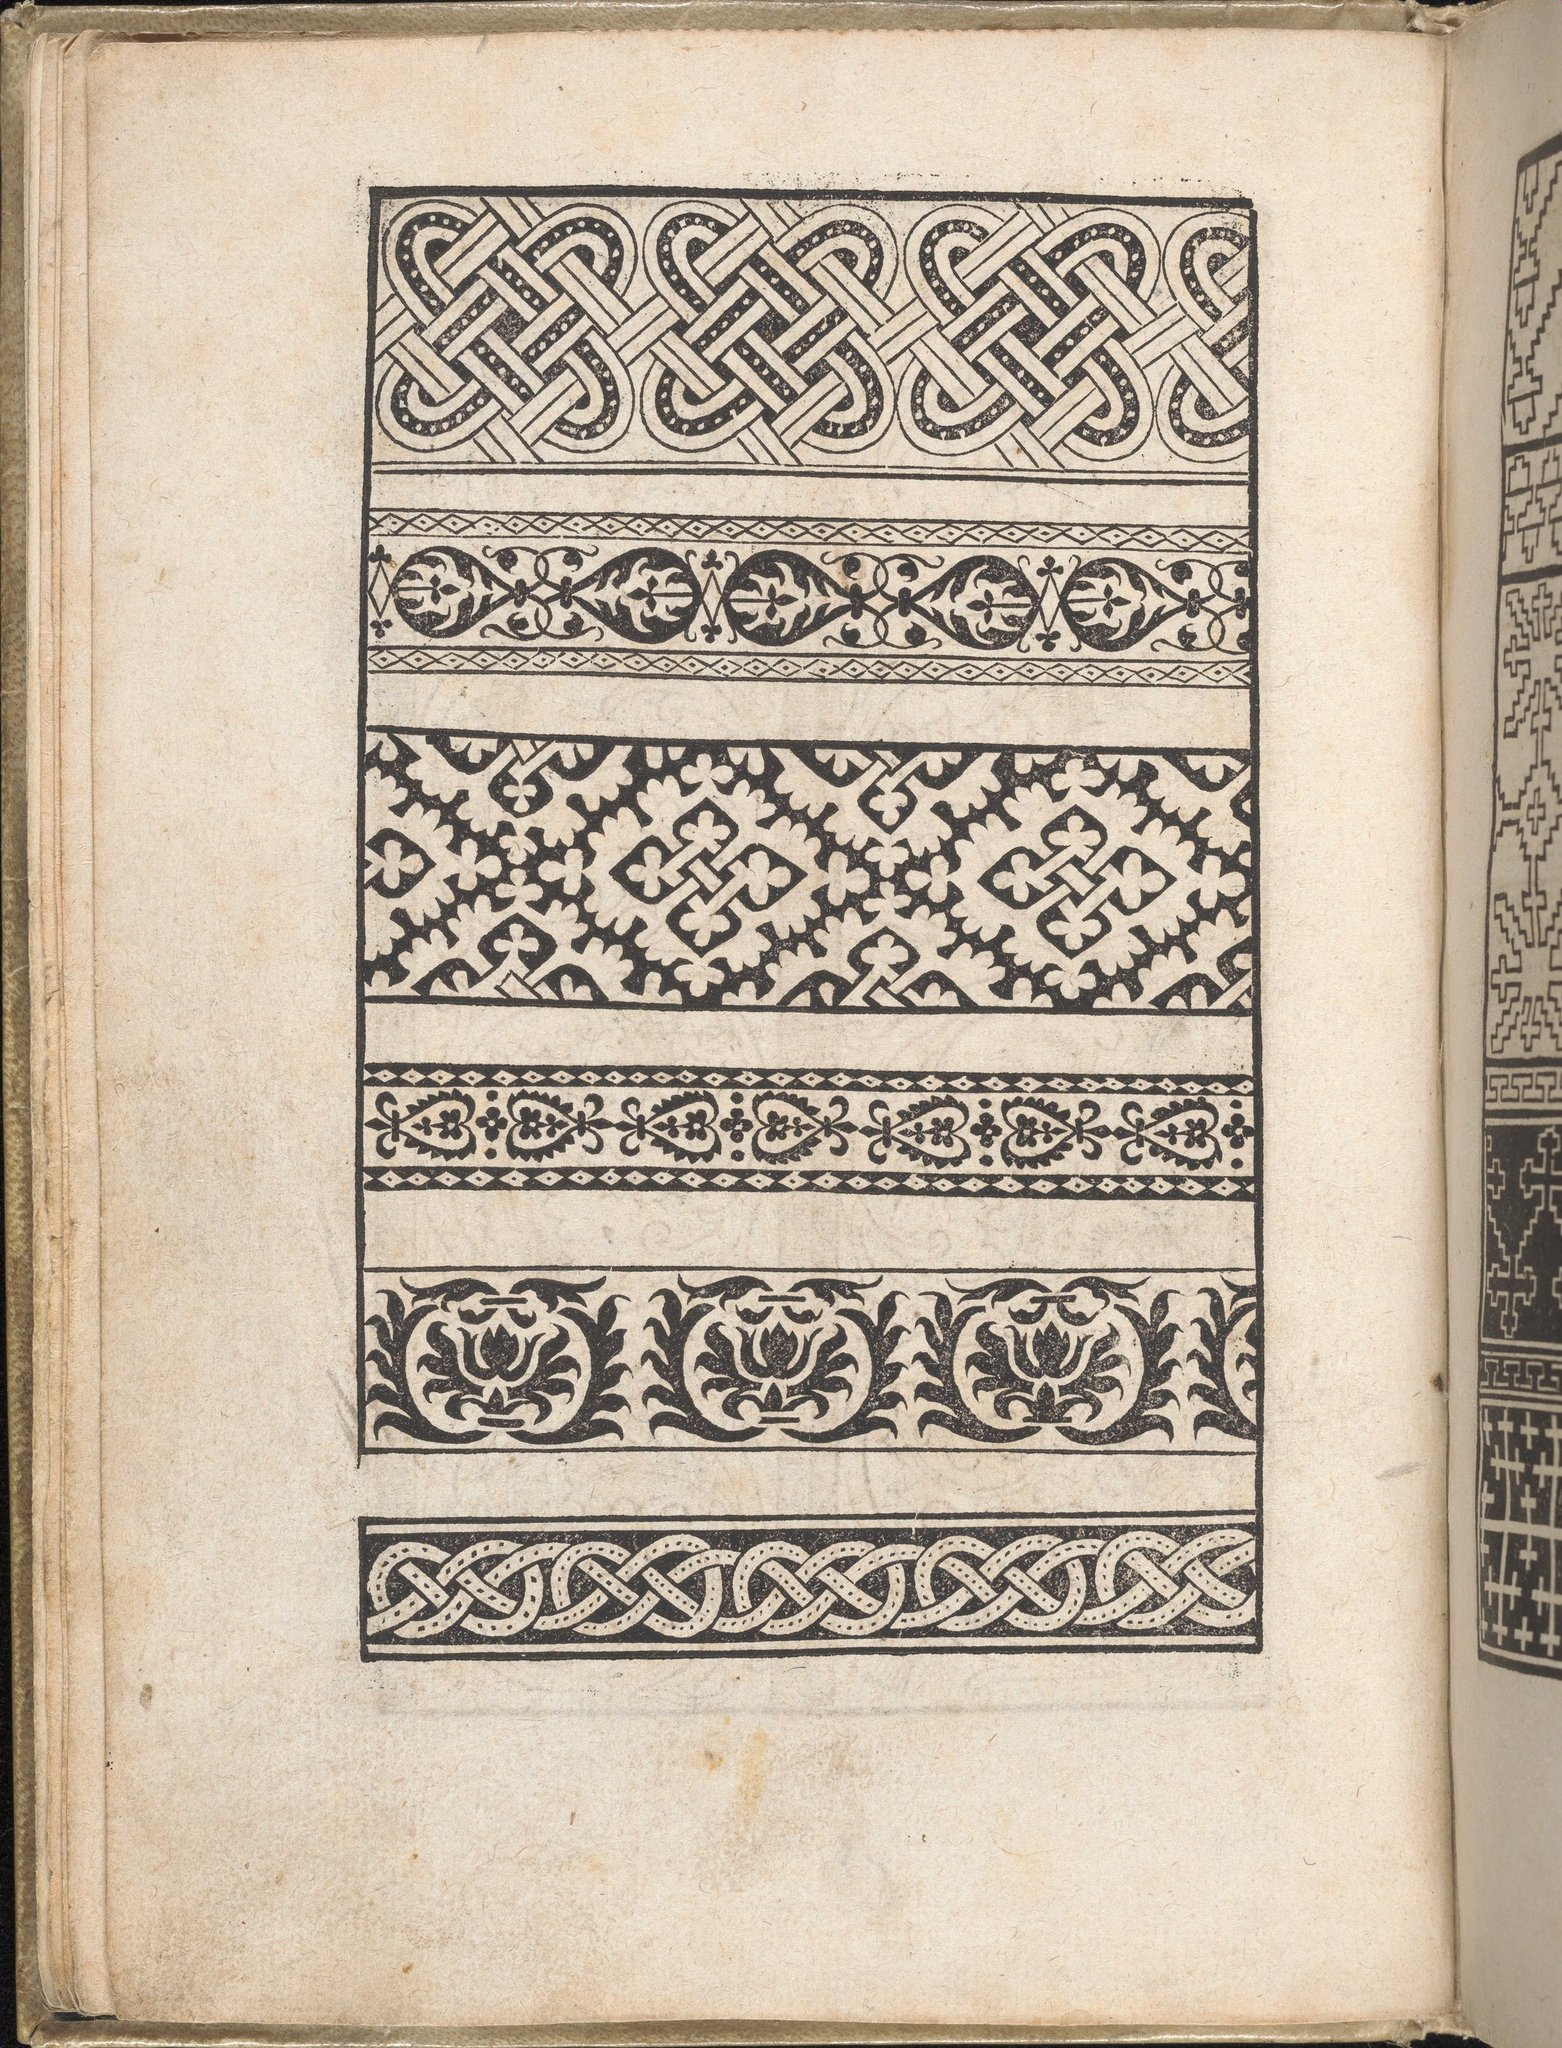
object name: book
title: Page 6r, from "Eyn New Kunstlichboich"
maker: peter quentel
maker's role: publisher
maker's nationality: german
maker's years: 1500-1550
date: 1529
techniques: woodcut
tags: ornament